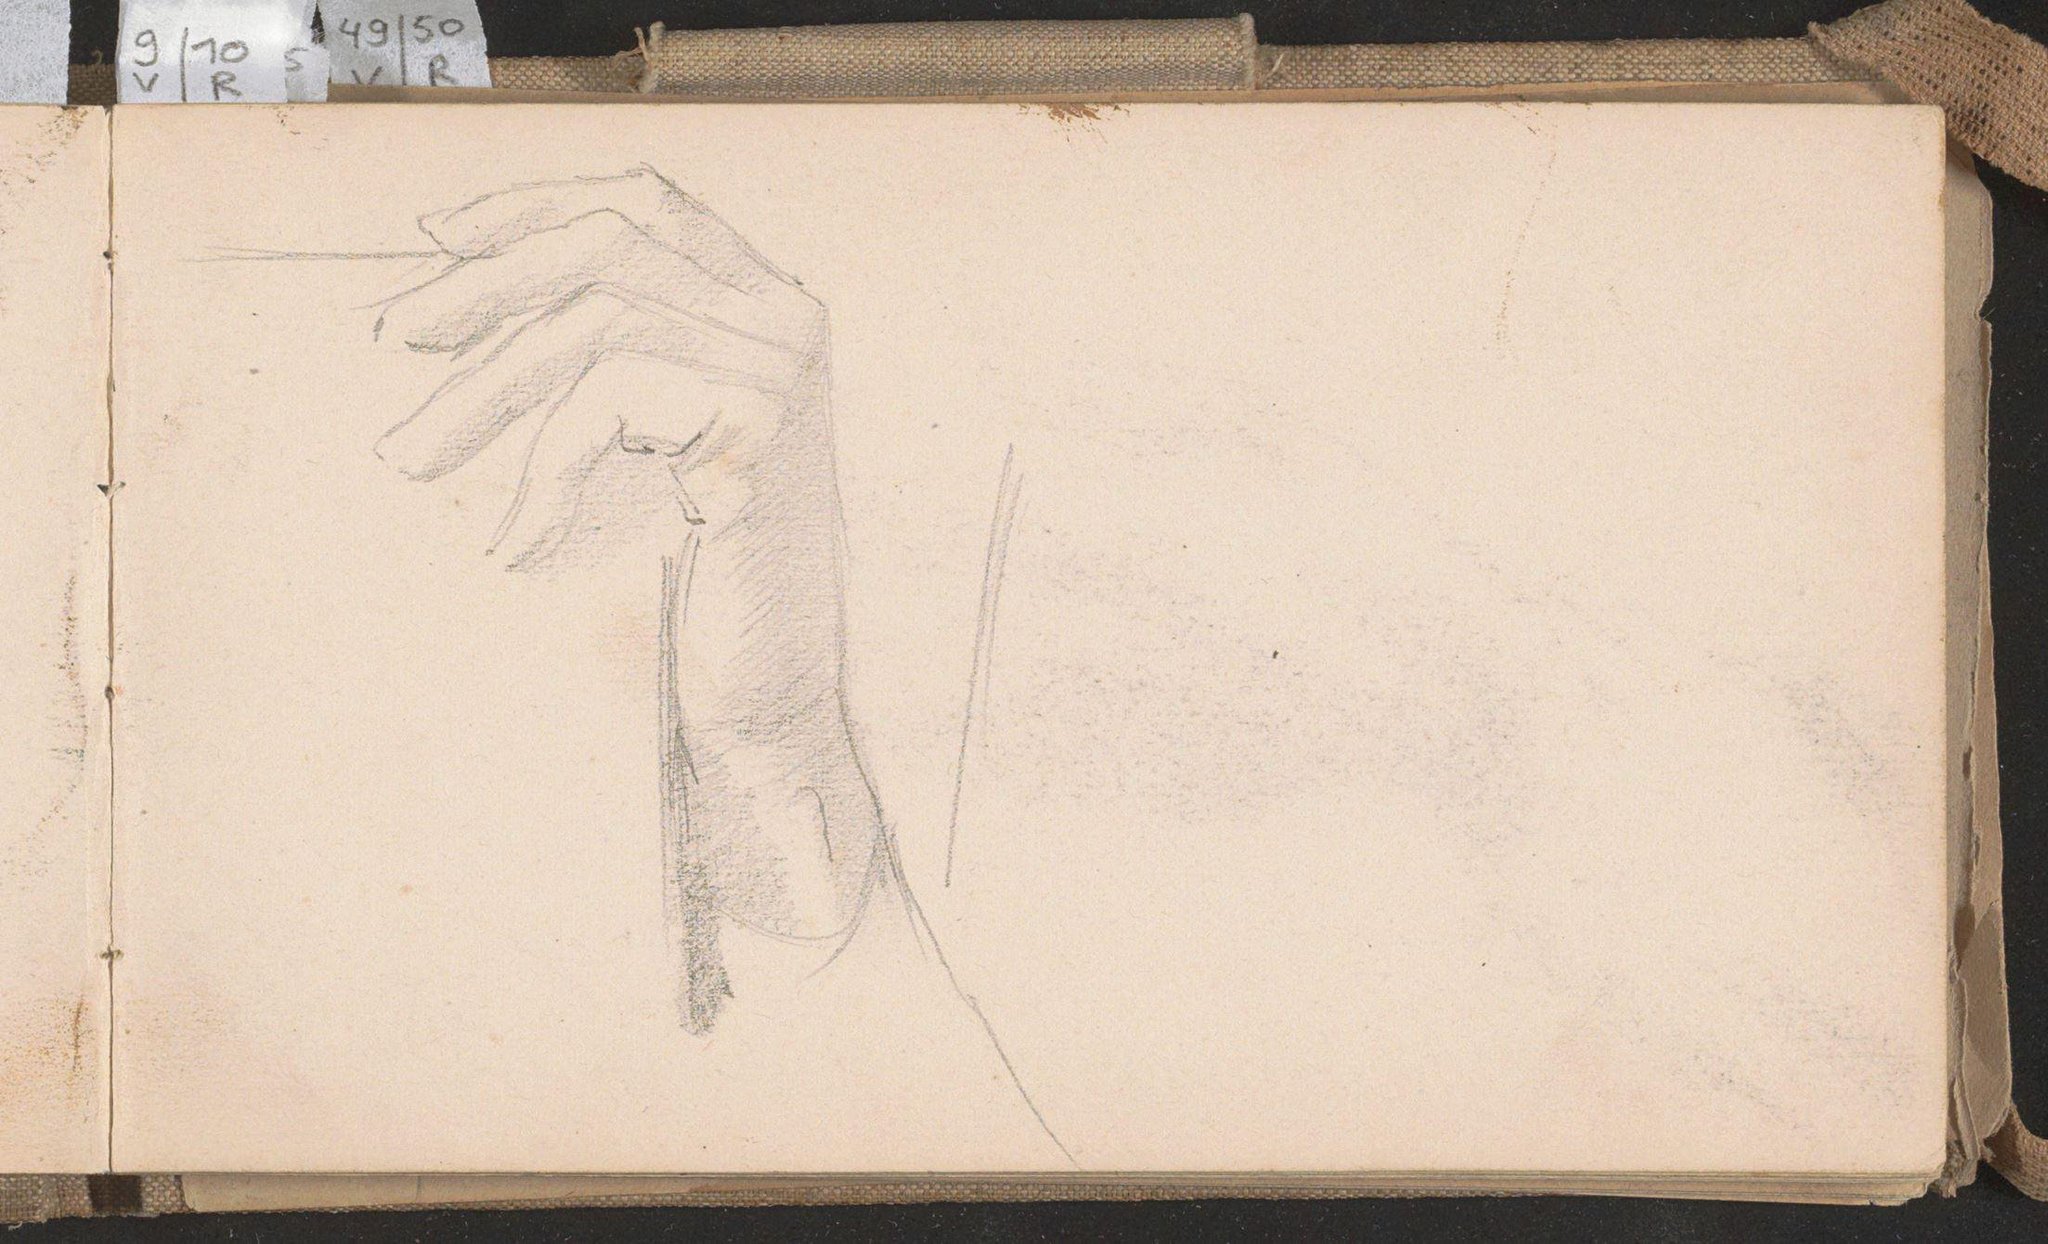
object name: sketchbook leaf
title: Hand die een blad of boek vasthoudt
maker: antoon derkinderen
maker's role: draughtsman, painter, print maker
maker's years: 1859-1925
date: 1892-1901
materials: paper, pencil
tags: hand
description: Blad 9 recto uit een schetsboek met 51 bladen.